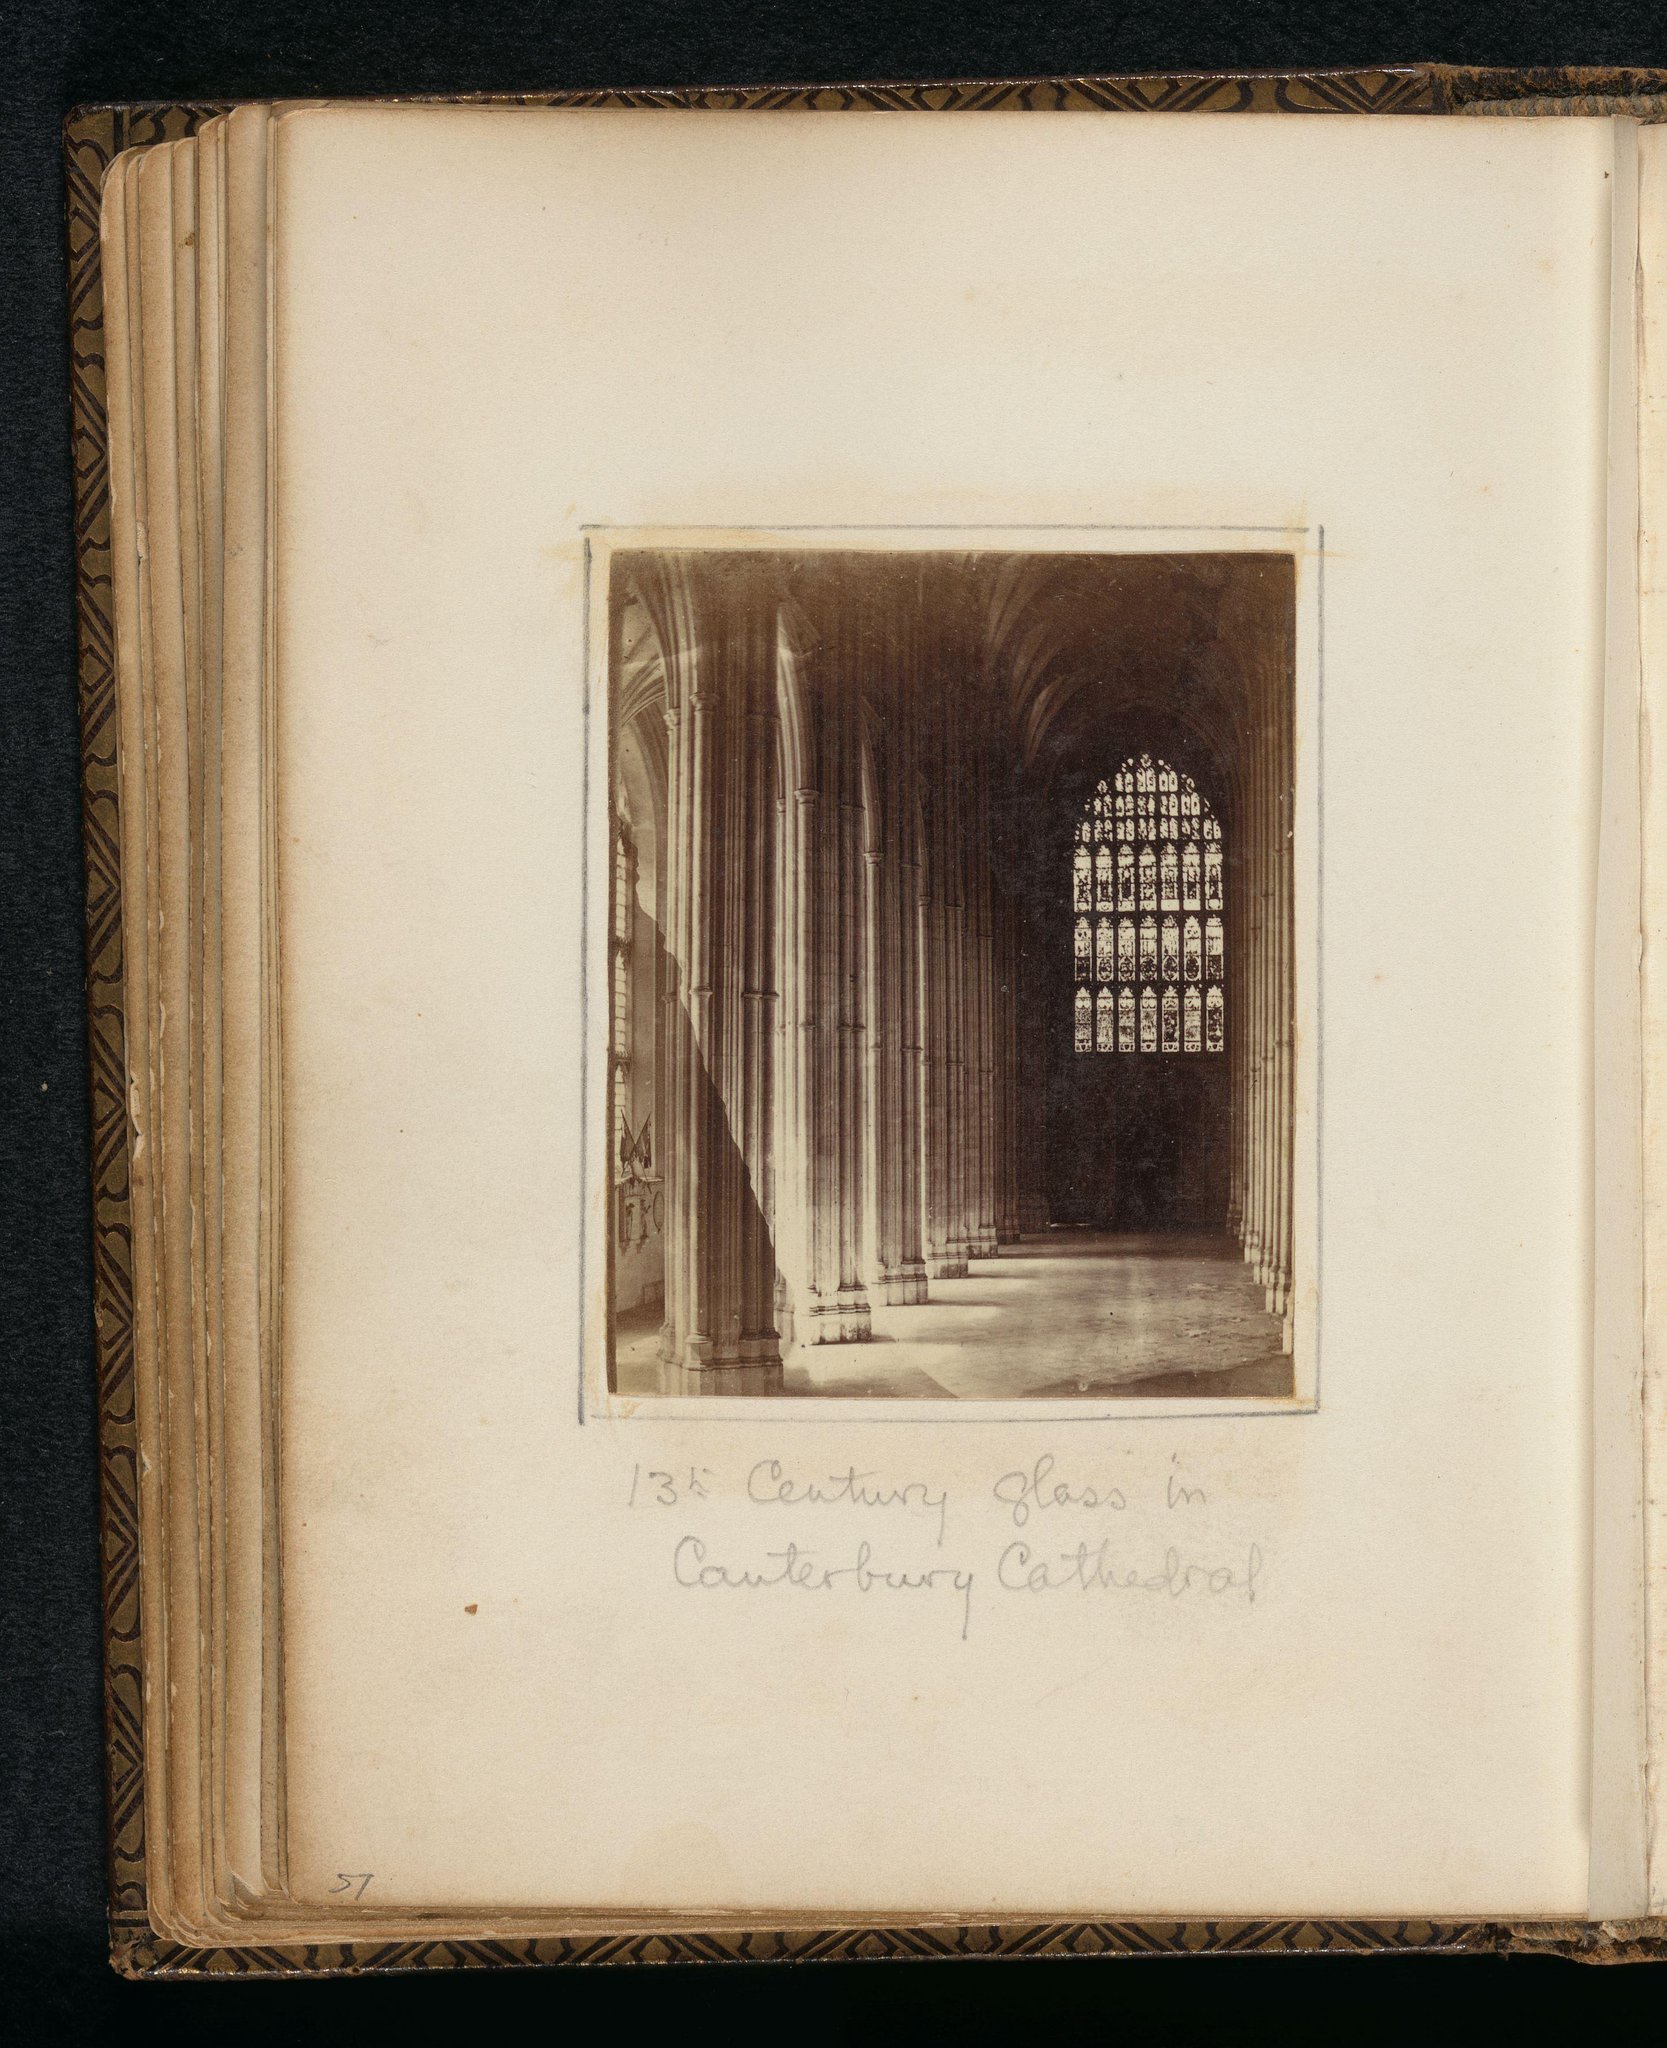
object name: album leaf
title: Glasraam in de kathedraal van Canterbury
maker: Anonymous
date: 1865-1867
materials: cardboard, photographic support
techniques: albumen print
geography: england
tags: church-window, e.g. rose-window, interior of church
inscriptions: annotation: ‘13th Century glass in Canterbury Cahthedral’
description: Glasraam in de kathedraal van Canterbury. Foto op albumblad in album met 68 foto's merendeels met geaquarelleerde randversieringen. Het zijn voornamelijk portretten op carte-de-visite formaat.